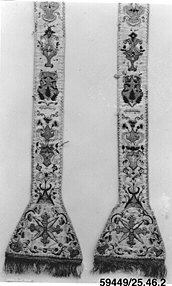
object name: stole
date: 1700